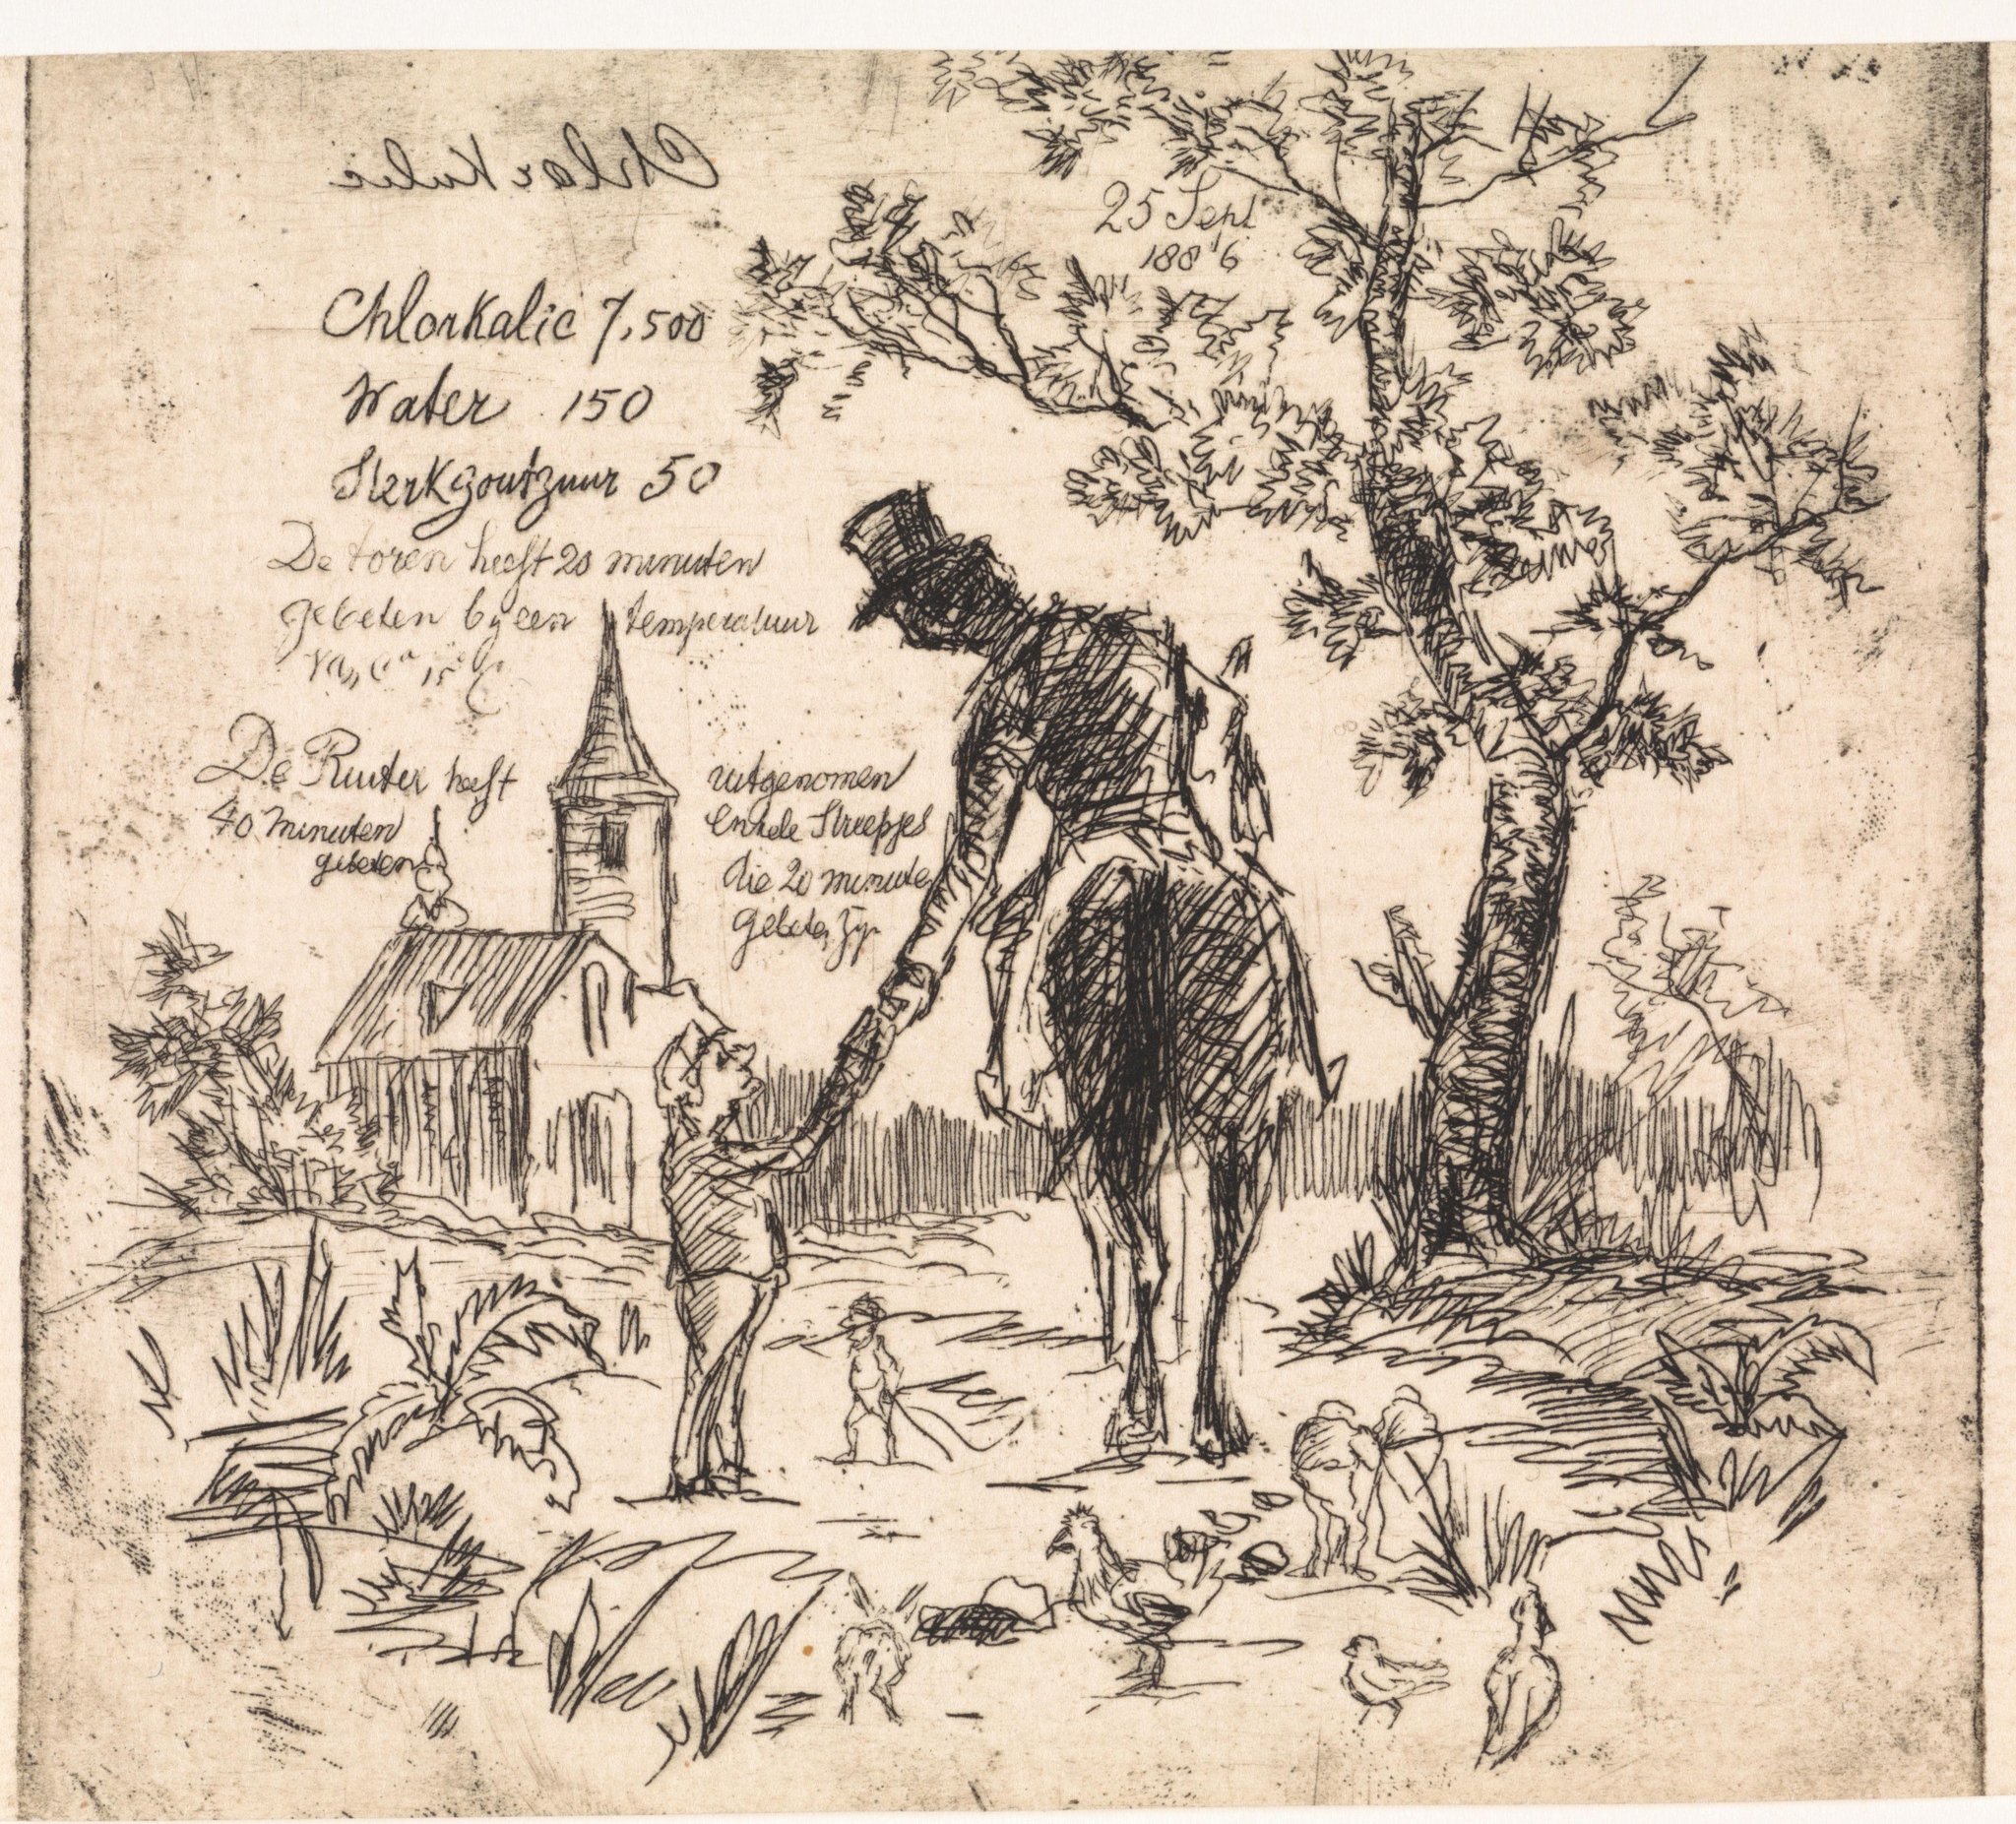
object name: print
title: Studieblad met ruiter in een landschap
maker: elias stark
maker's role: draughtsman, print maker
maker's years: 1849-1933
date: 1886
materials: paper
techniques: etching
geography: nieuwer-amstel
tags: riding a horse, ass, or mule; rider, horseman, church (exterior)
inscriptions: collector's mark: Lugt 2228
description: Landschap met een man te paard, die iets aan een kind geeft of aanpakt. Op de achtergrond een kerk. In de lucht aantekeningen over de duur van het uitbijten van bepaalde delen van de plaat.